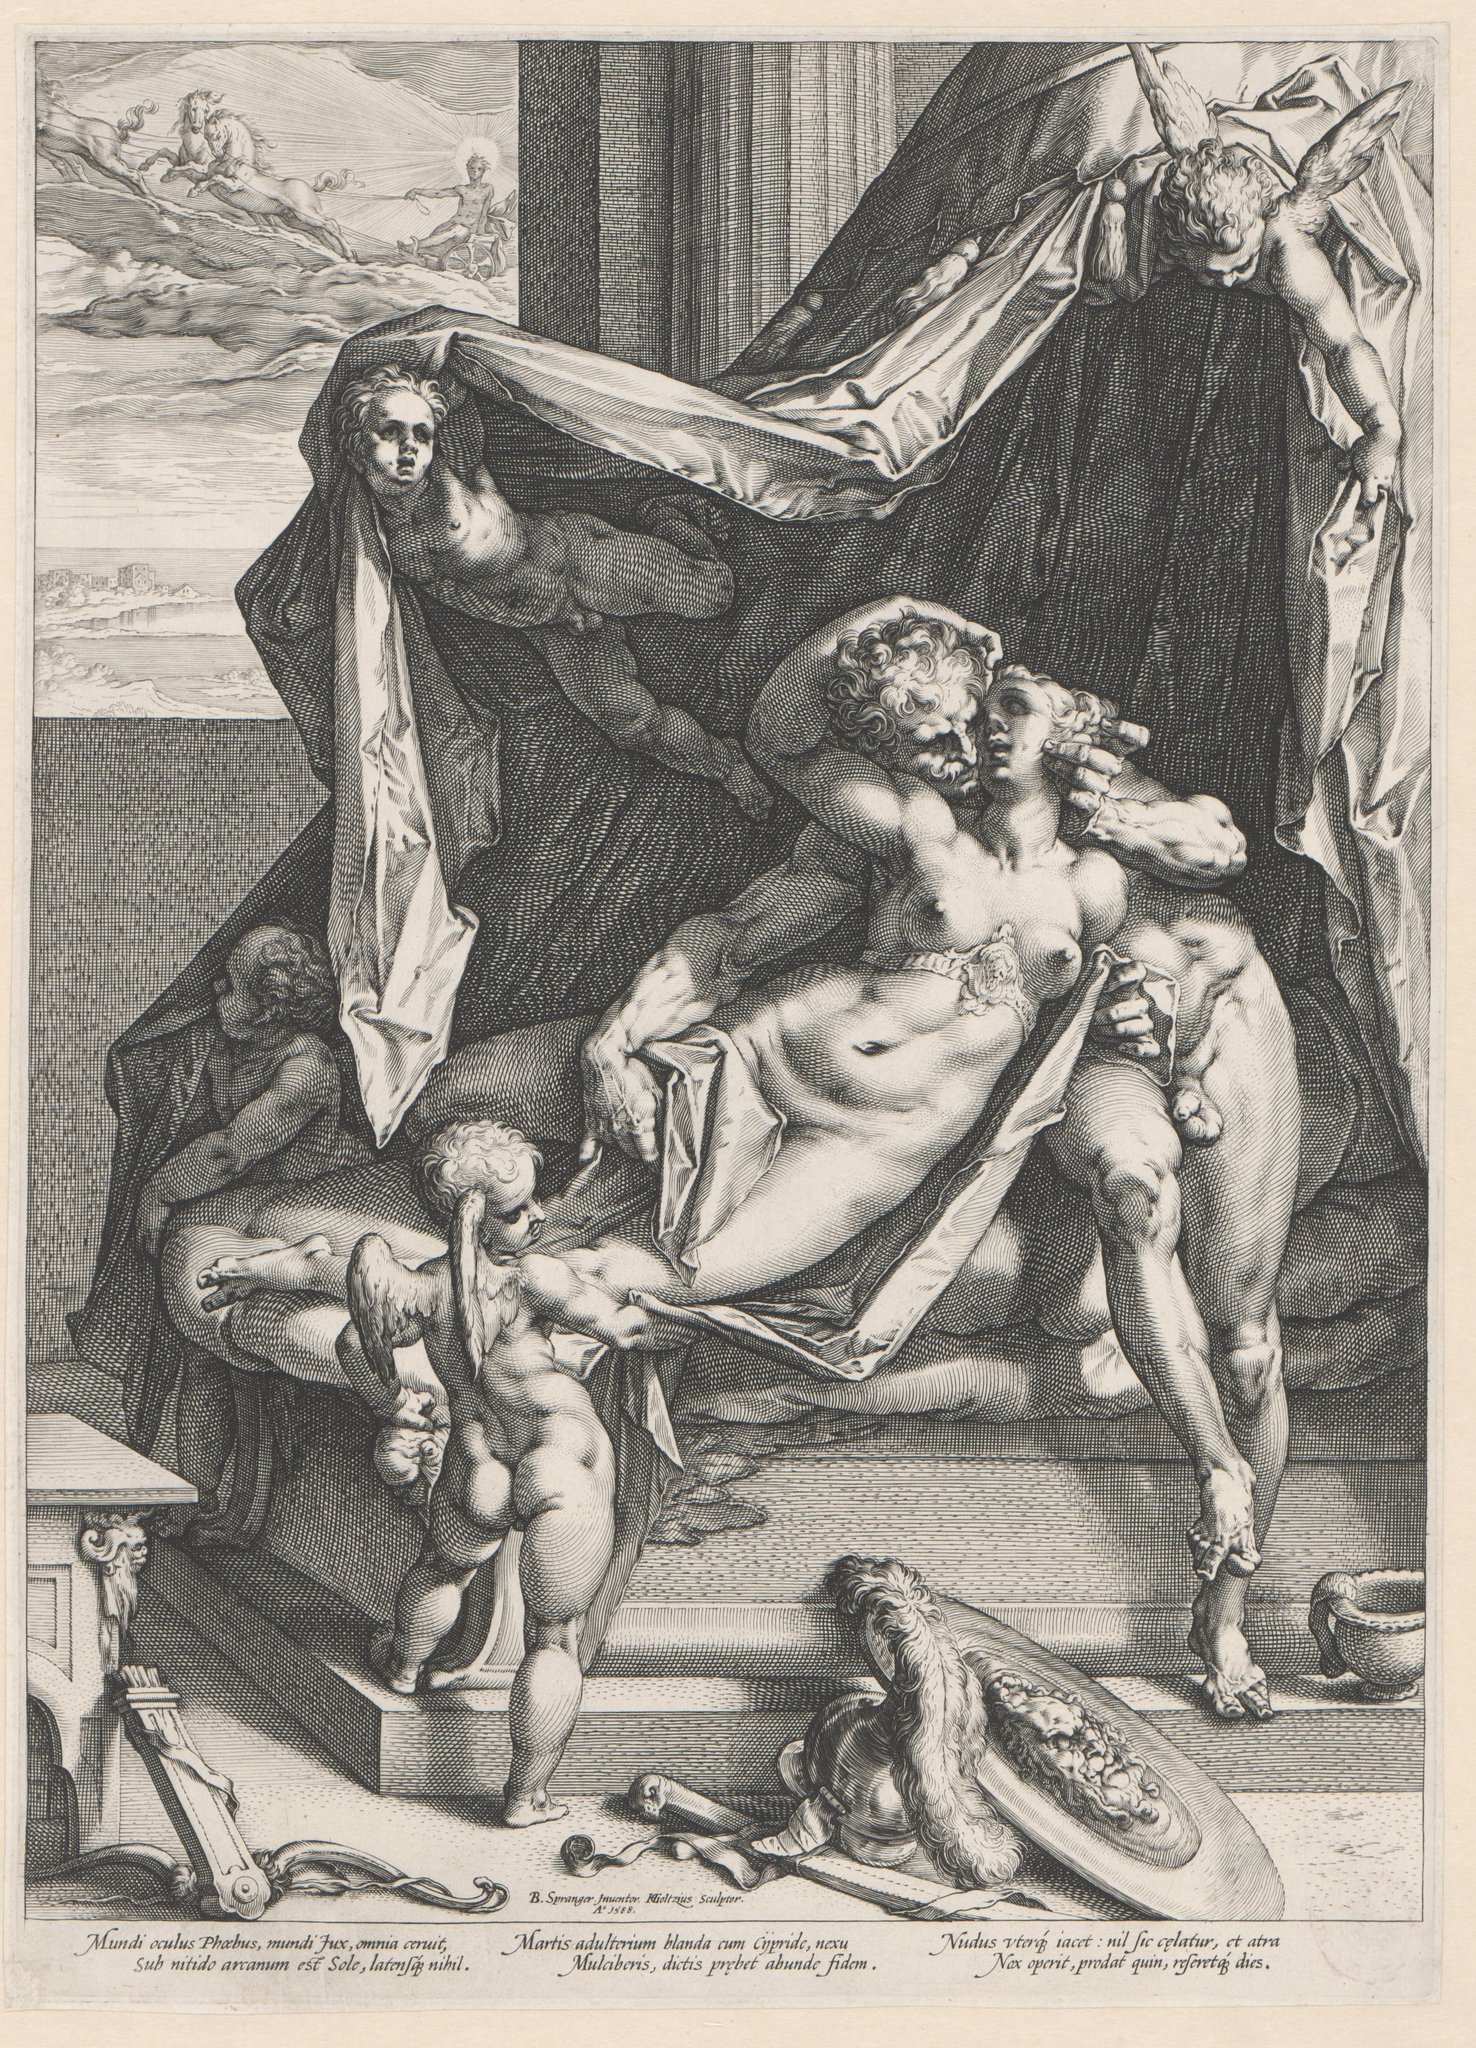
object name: print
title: Mars en Venus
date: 1588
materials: paper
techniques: engraving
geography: haarlem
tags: mars and venus as lovers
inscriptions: caption: ‘Mundi oculos Phoebus.../.../...referta dies.’, signature: ‘B.Spranger Jnuentor.’, collector's mark: Lugt 240, date: ‘Ao 1588’, signature: ‘HGoltzius sculptor.’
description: Mars en Venus liggen samen in bed, engeltjes staan en vliegen om hen heen, Cupido staat bij het voeteneind. Door het raam is te zien dat Apollo eraan komt op zijn zonnewagen. onder de voorstelling drie maal twee Latijnse versregels.